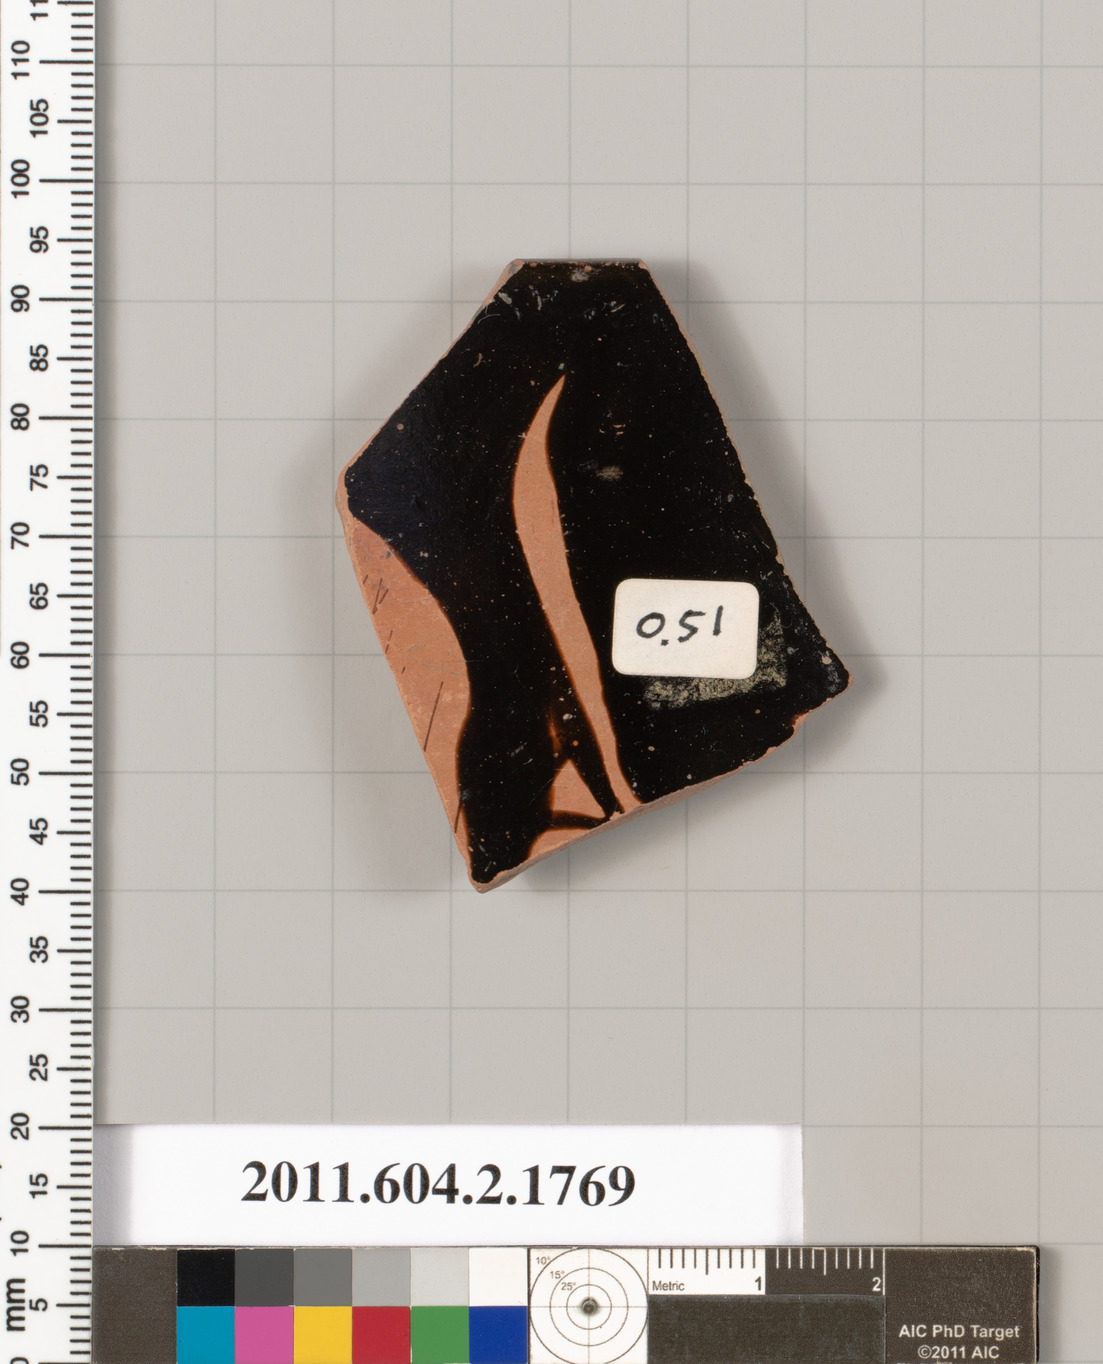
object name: skyphos fragment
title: Terracotta rim fragment of a skyphos (deep drinking cup)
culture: greek, attic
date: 450-426 BCE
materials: terracotta